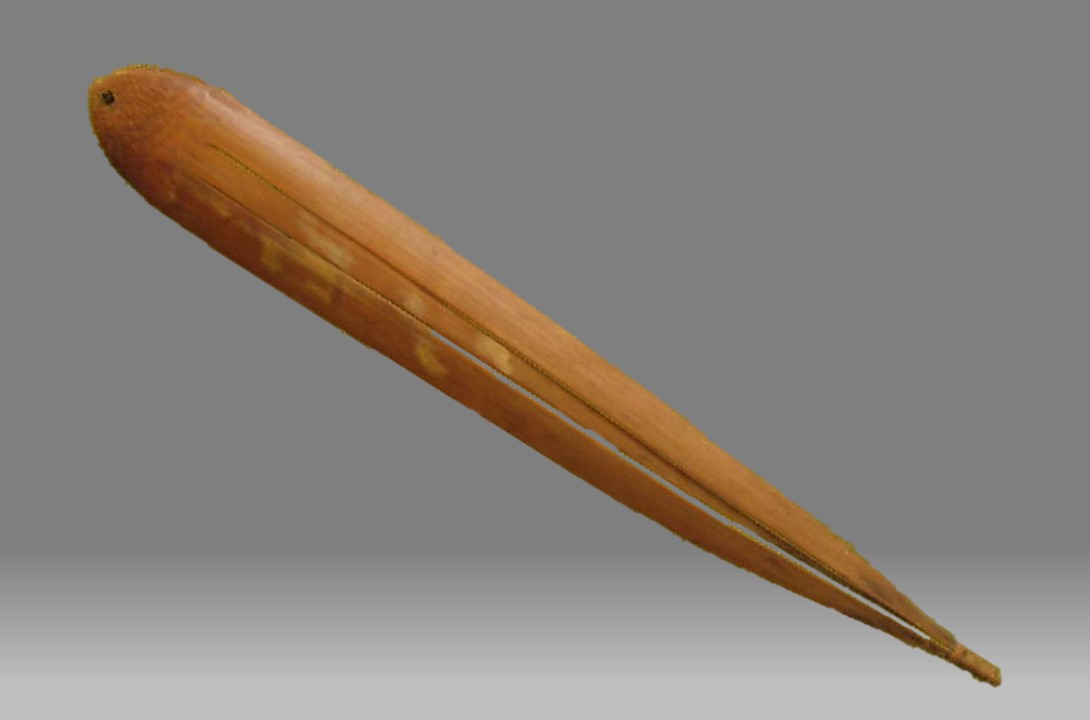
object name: rooria jew's harp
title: Jew's Harp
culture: new zealander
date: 1801-1900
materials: bamboo, fiber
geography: new zealand